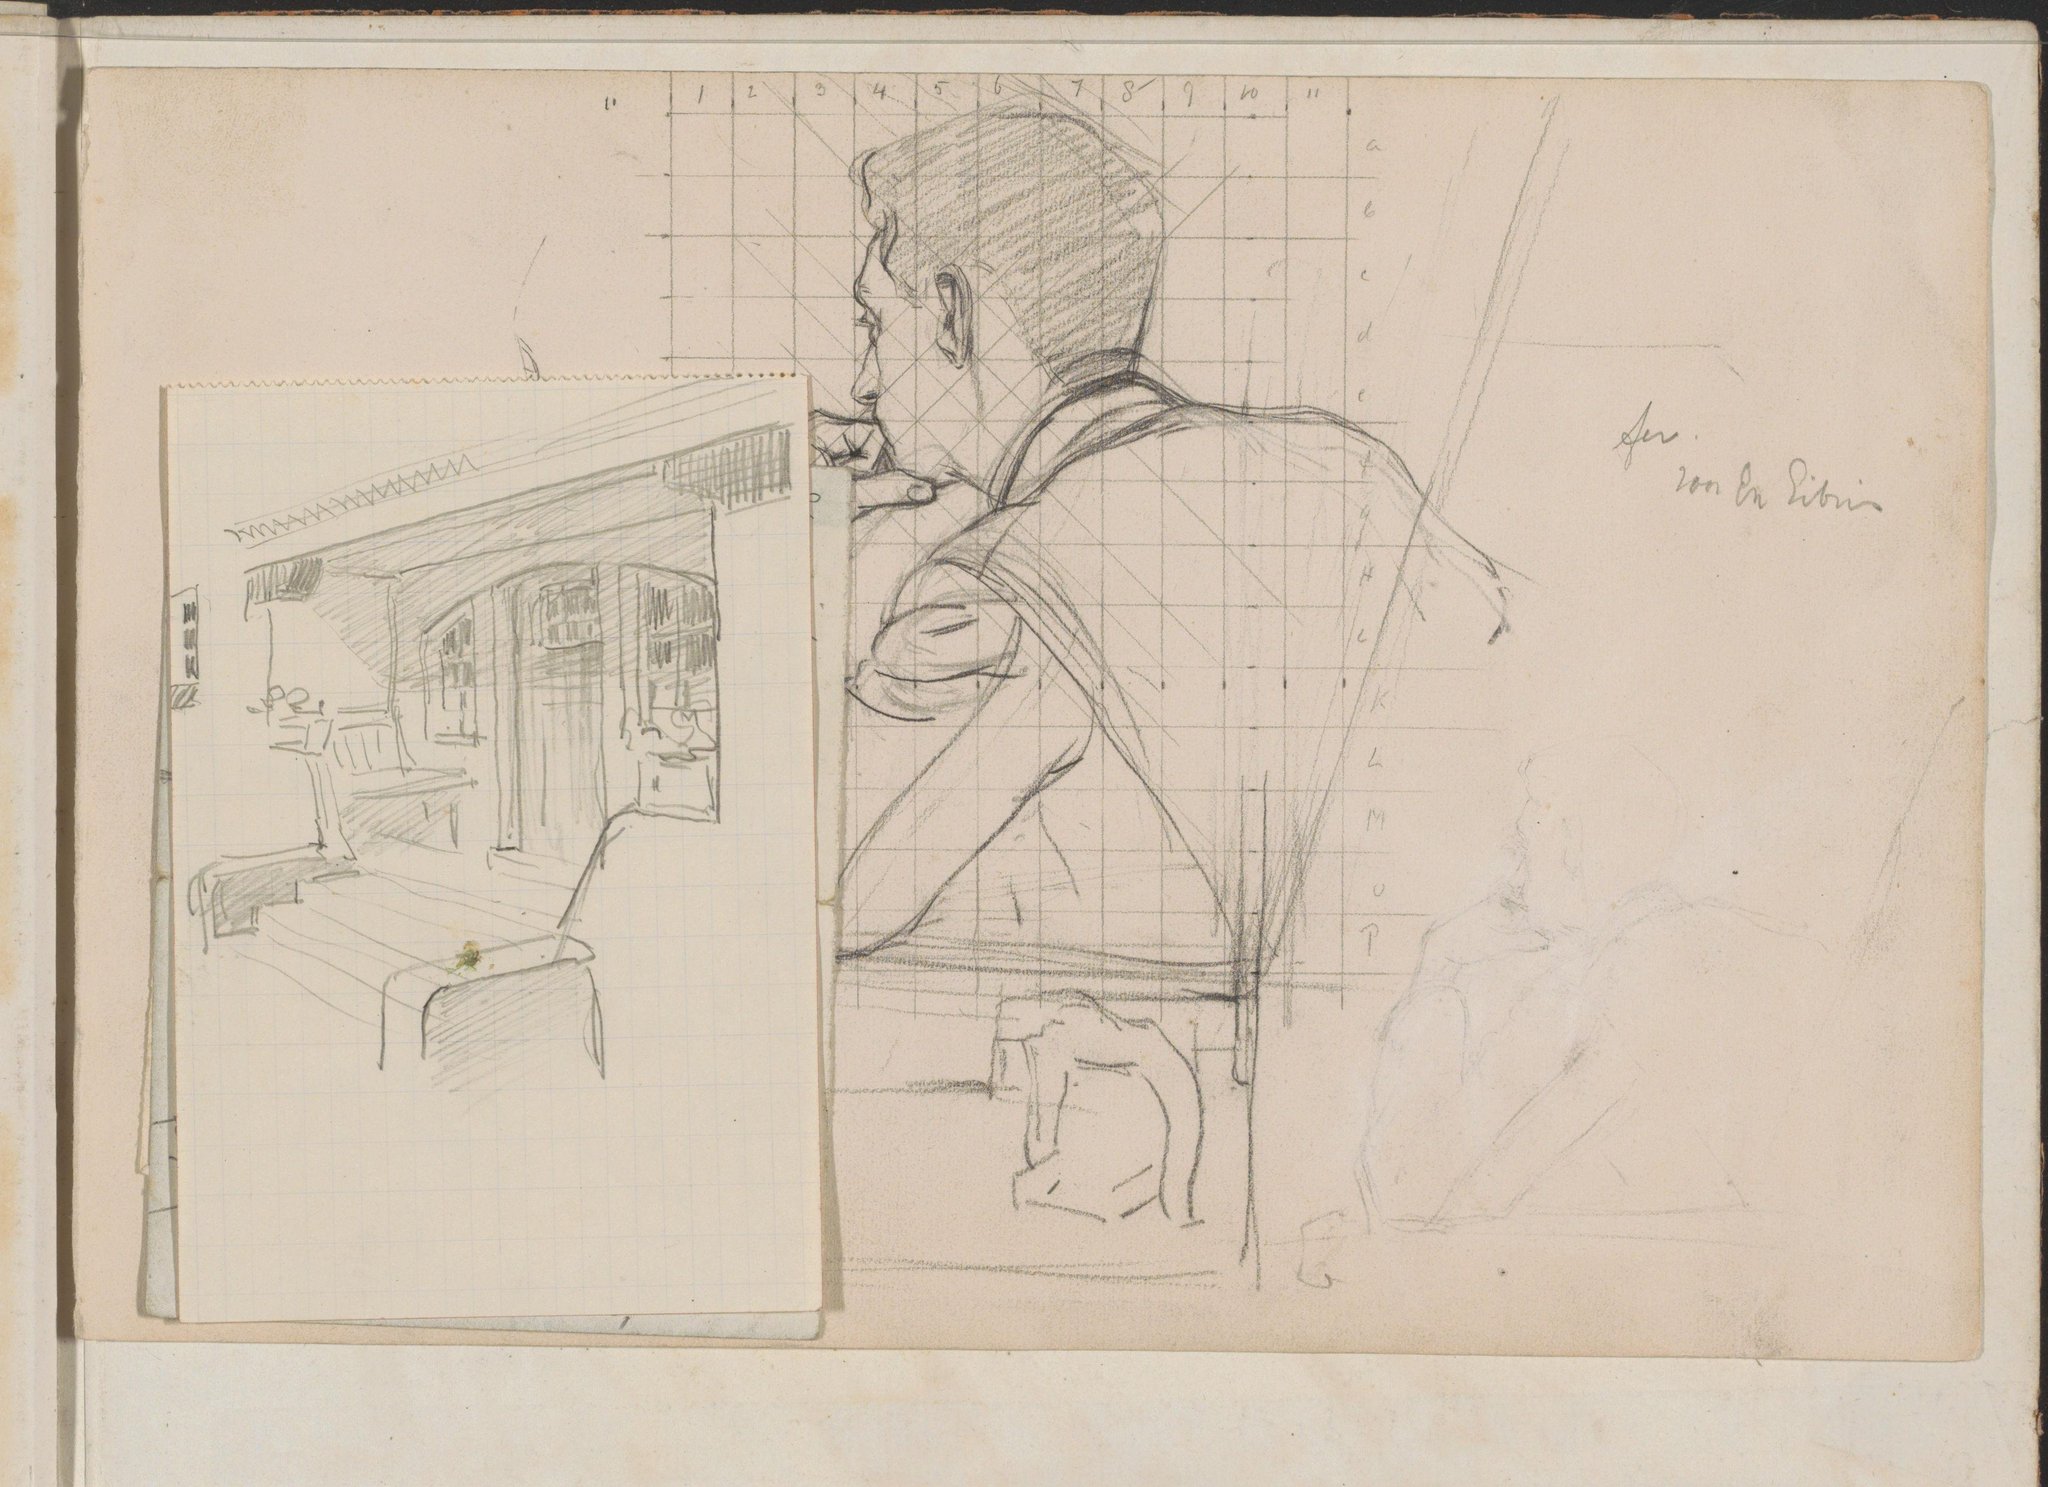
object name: sketchbook leaf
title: Vooraanzicht van een huis met veranda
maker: ferdinand oldewelt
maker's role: draughtsman, print maker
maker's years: 1857-1935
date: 1904-1912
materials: pencil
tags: loggia, verandah, porch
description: Los blad tussen blad 27 en het achterste schutblad uit een schetsboek met 27 bladen.